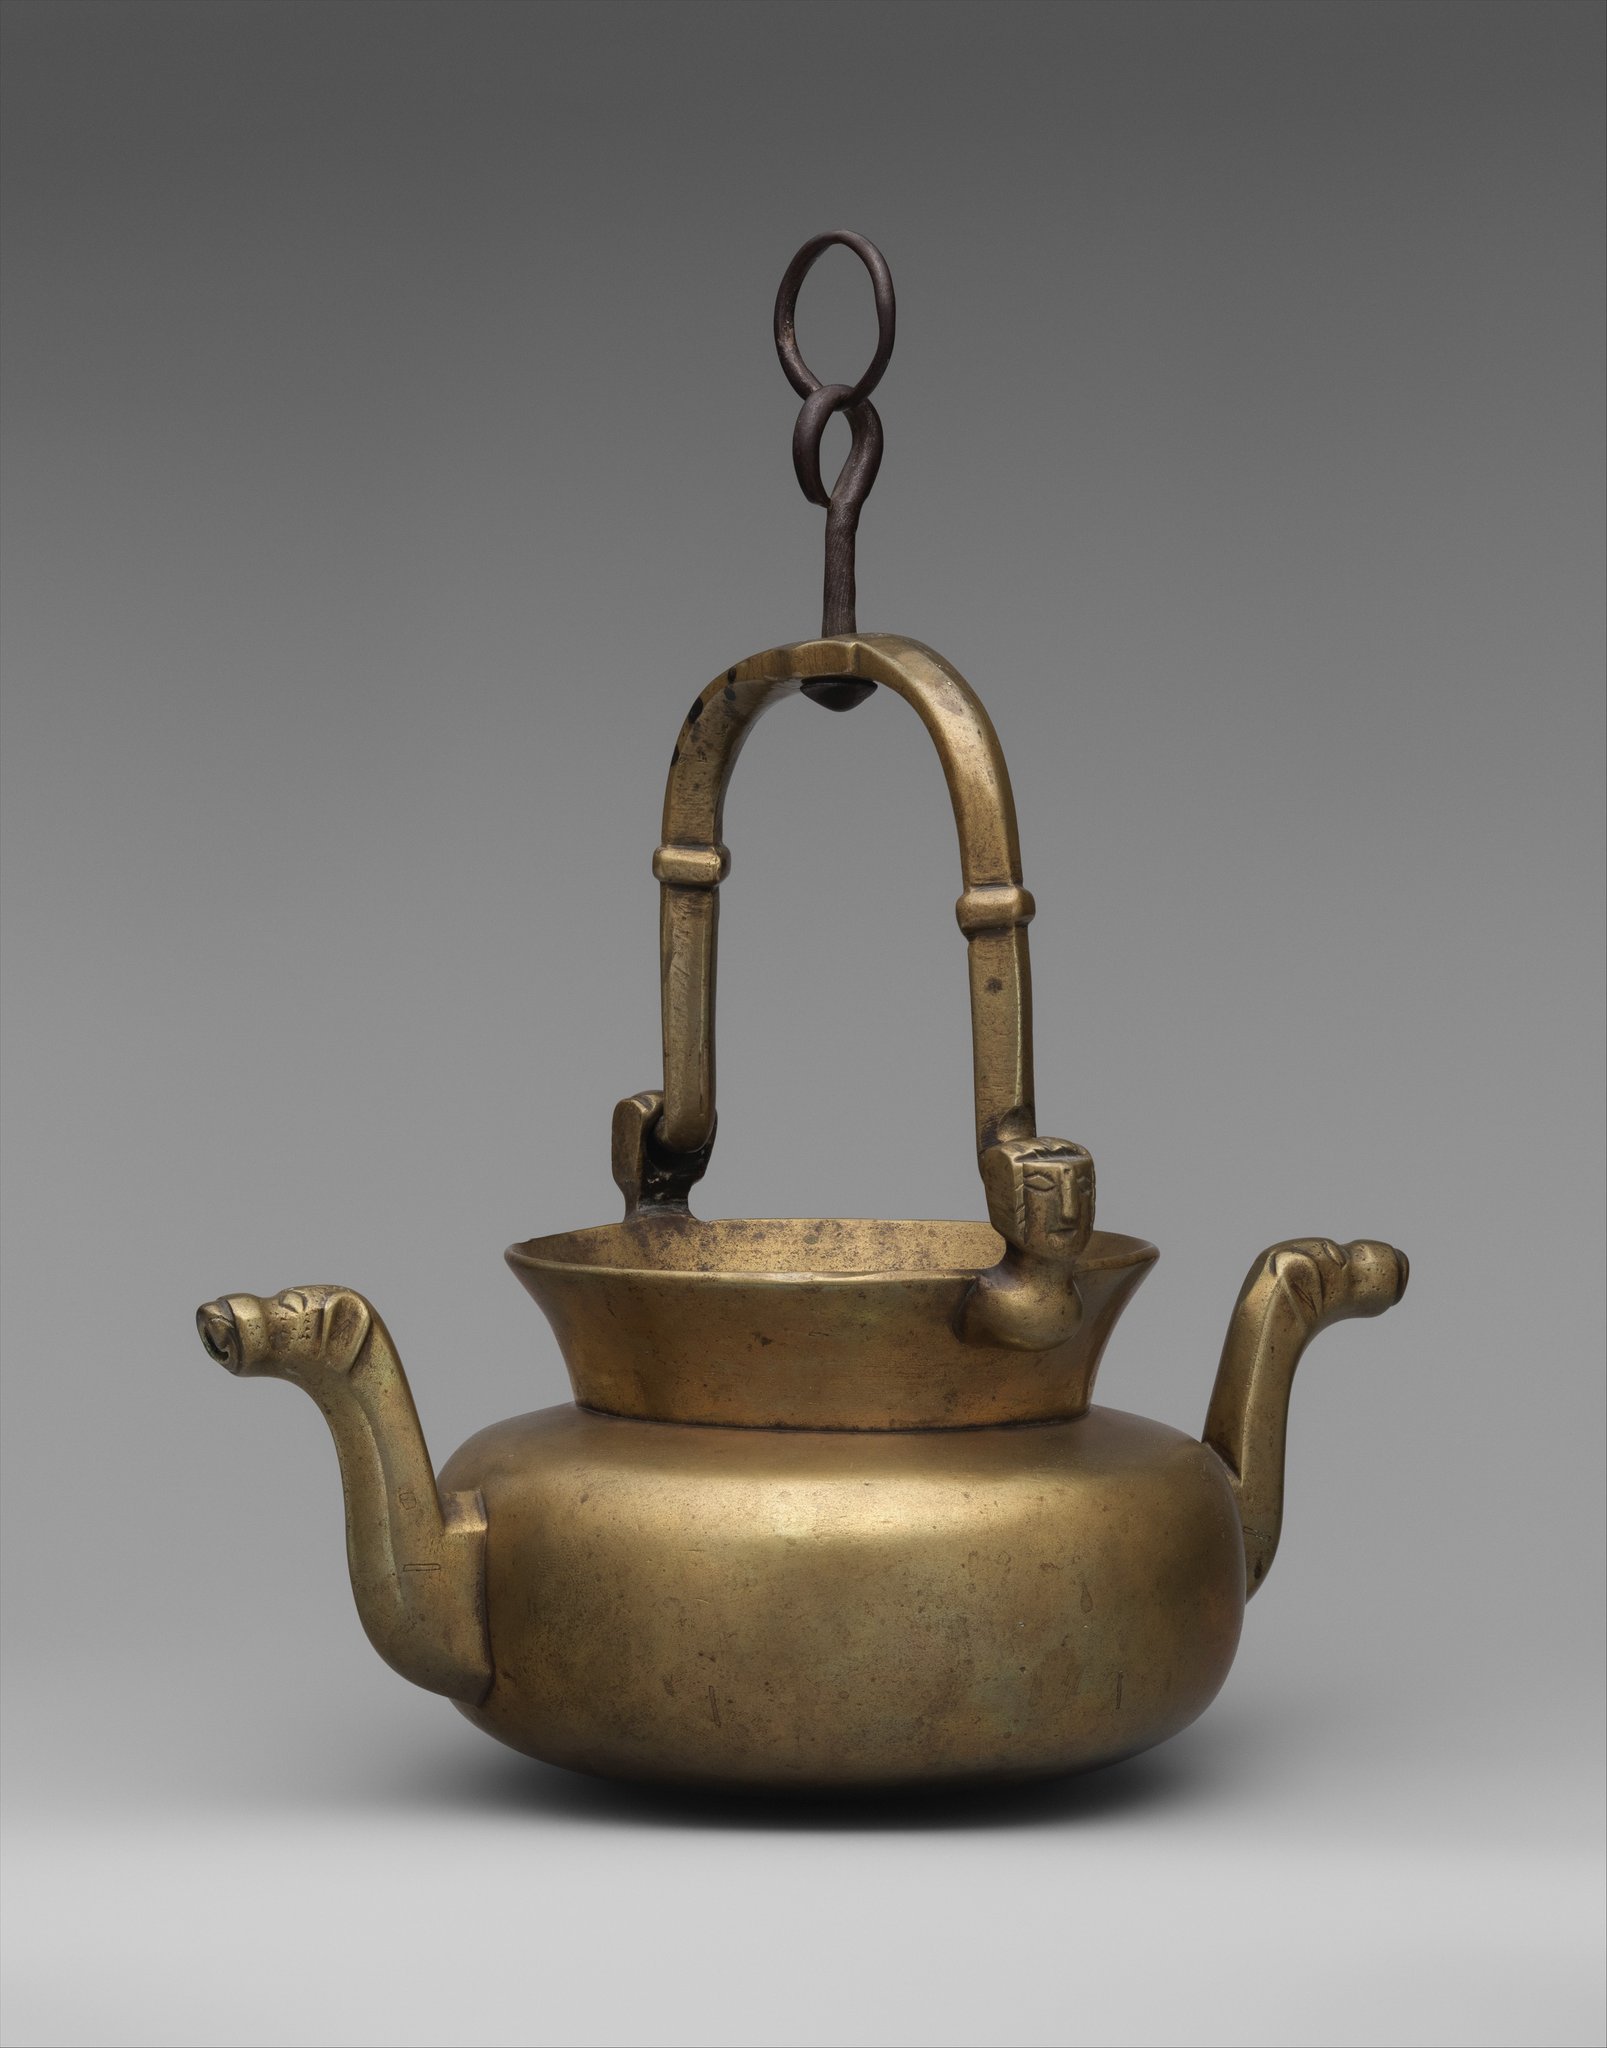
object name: laver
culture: dutch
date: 1401-1500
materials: brass, iron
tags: faces